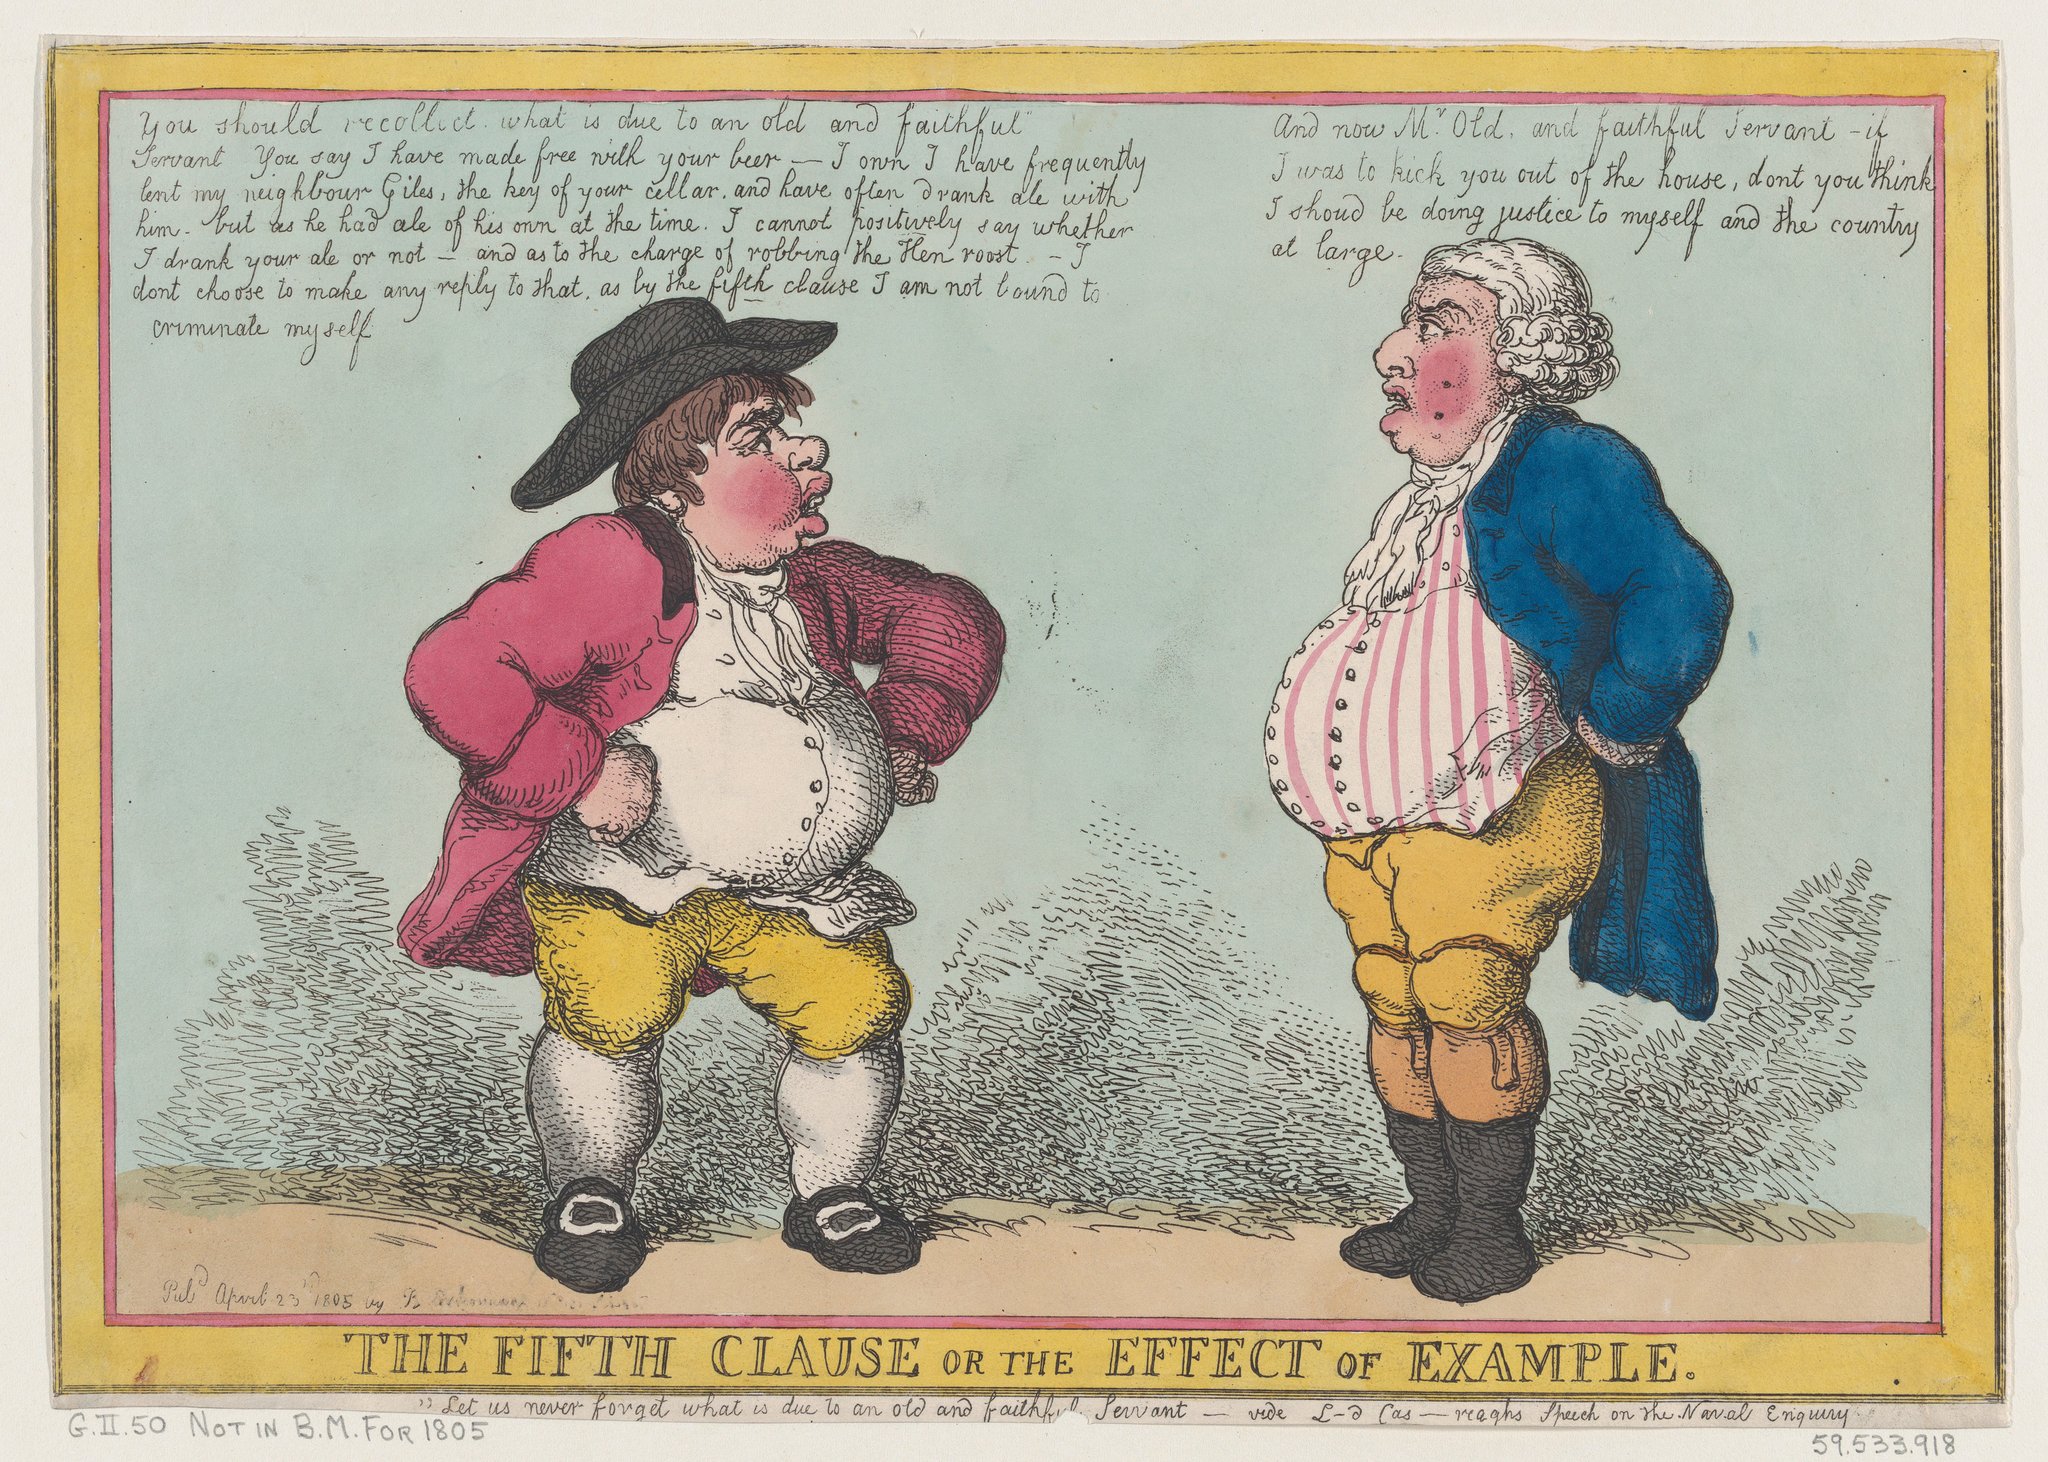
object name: print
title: The Fifth Clause, or the Effect of Example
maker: thomas rowlandson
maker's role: artist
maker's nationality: british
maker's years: 1757-1827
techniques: etching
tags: satire,men,politics